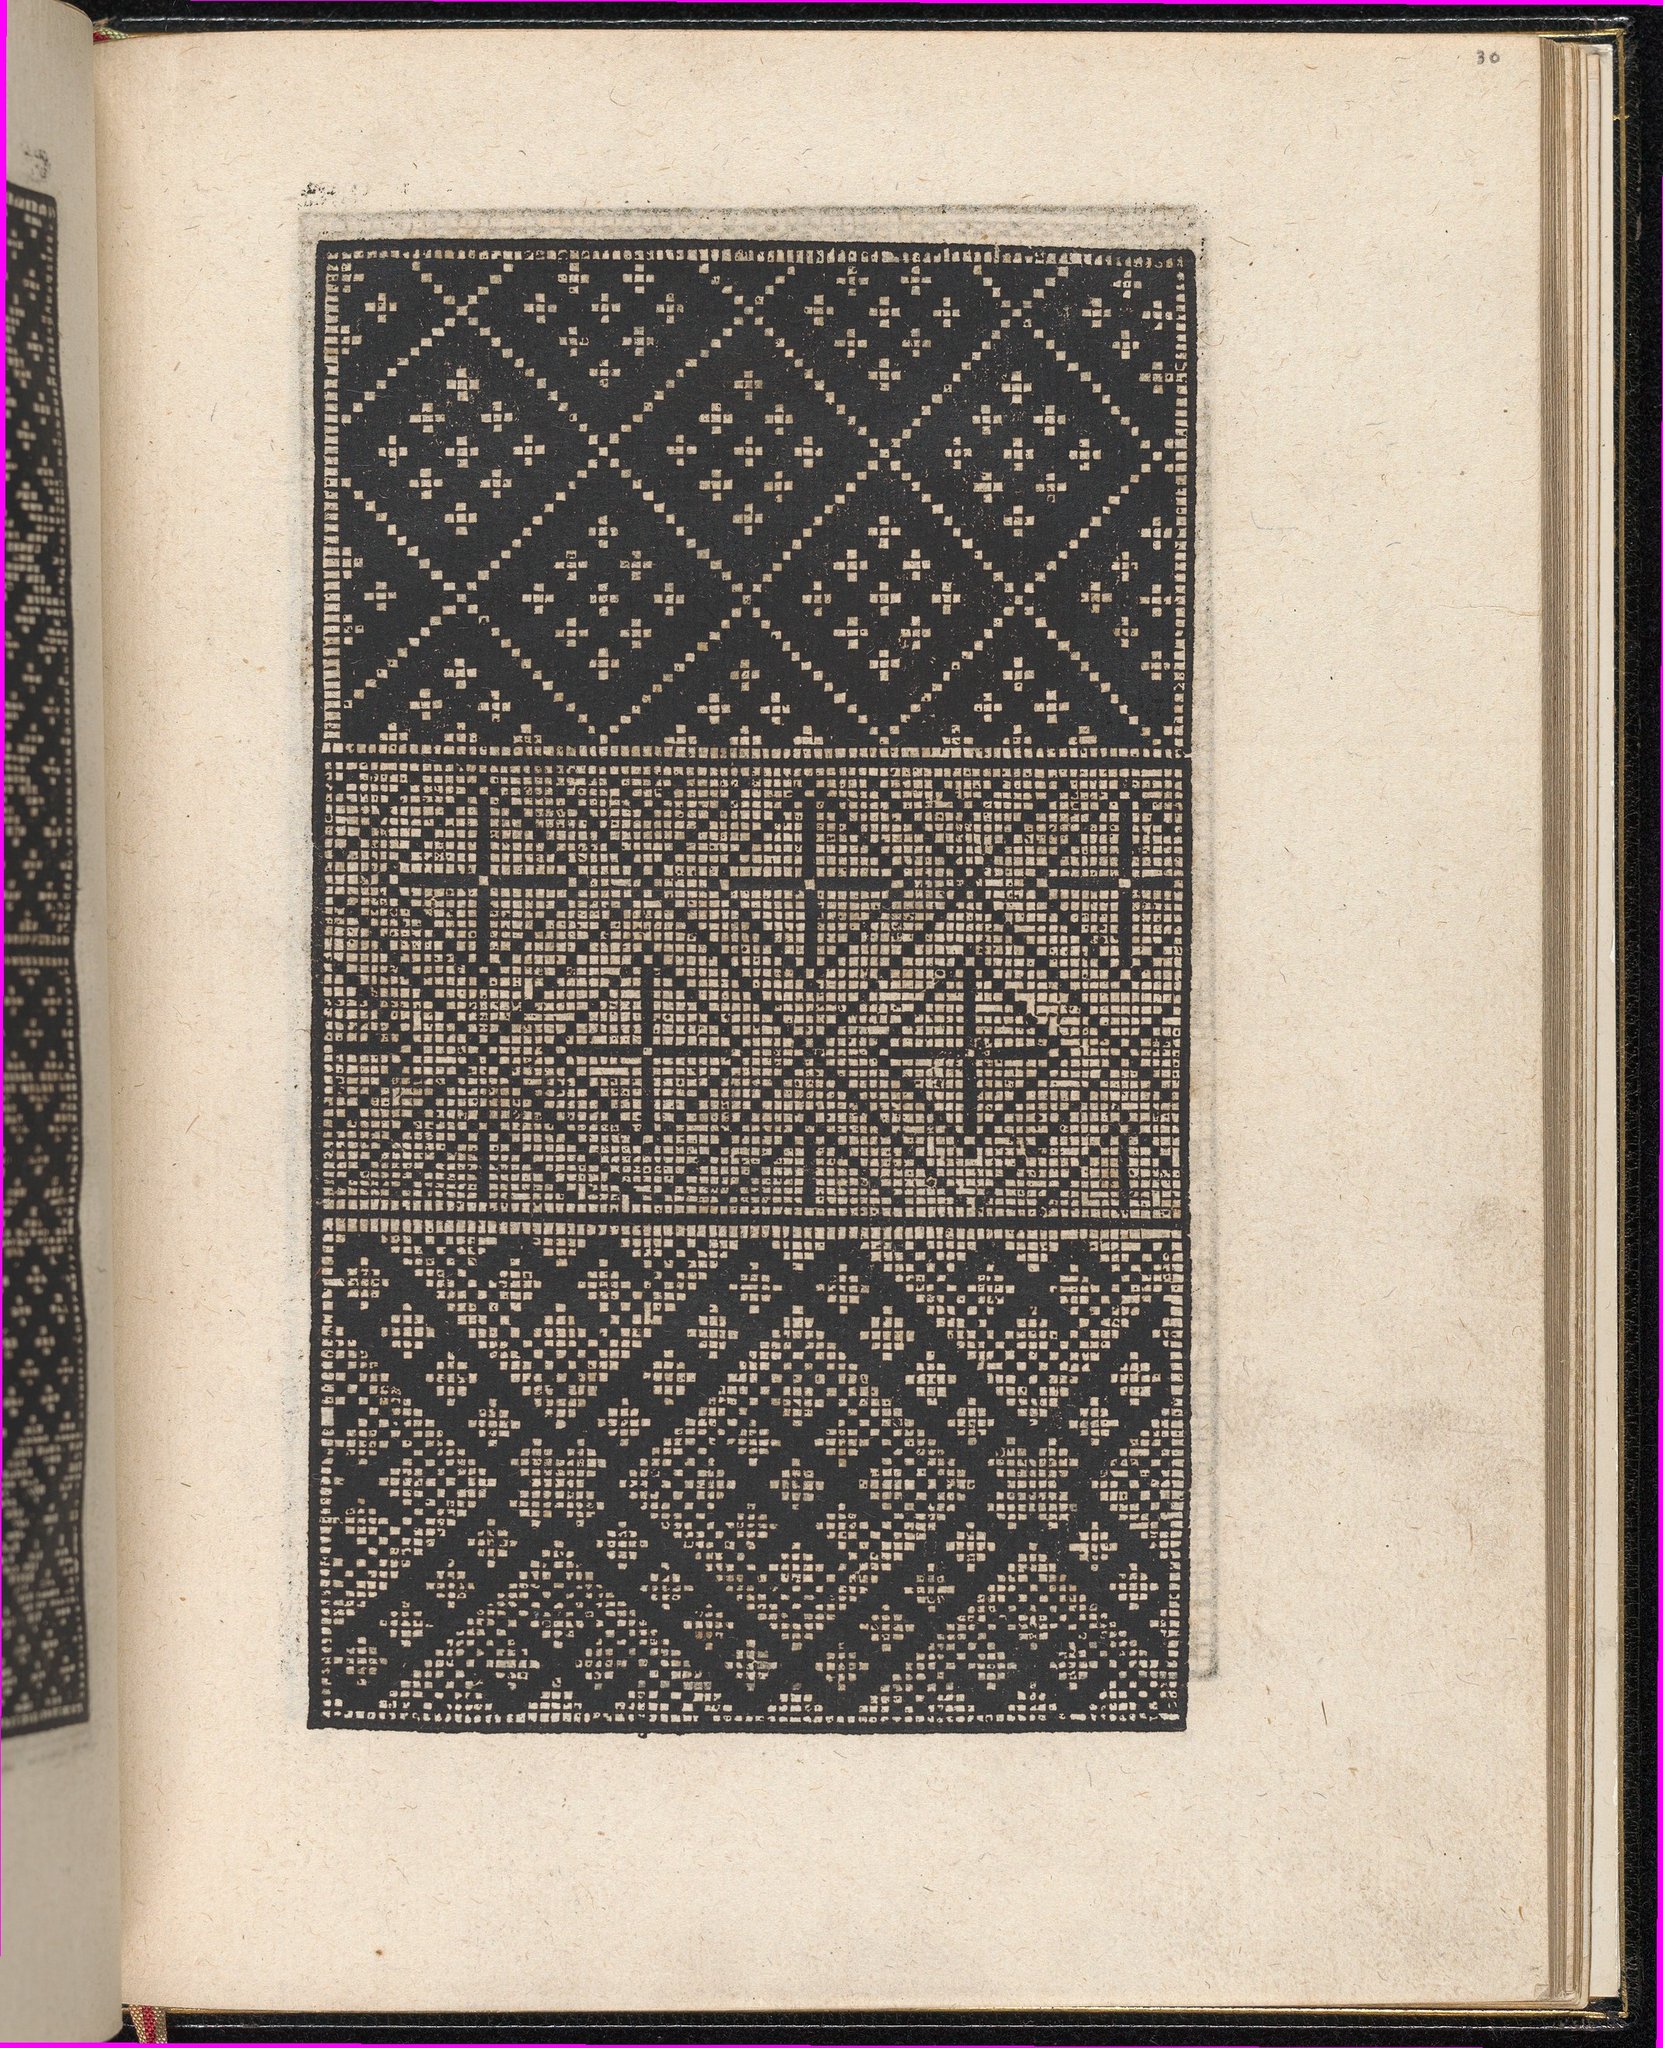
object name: book print ornament architecture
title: Page from Ein new kunstlich Modelbuch...(Page 30r)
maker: peter quentel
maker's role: publisher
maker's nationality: german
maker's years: 1500-1550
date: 1544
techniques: woodcut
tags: ornament